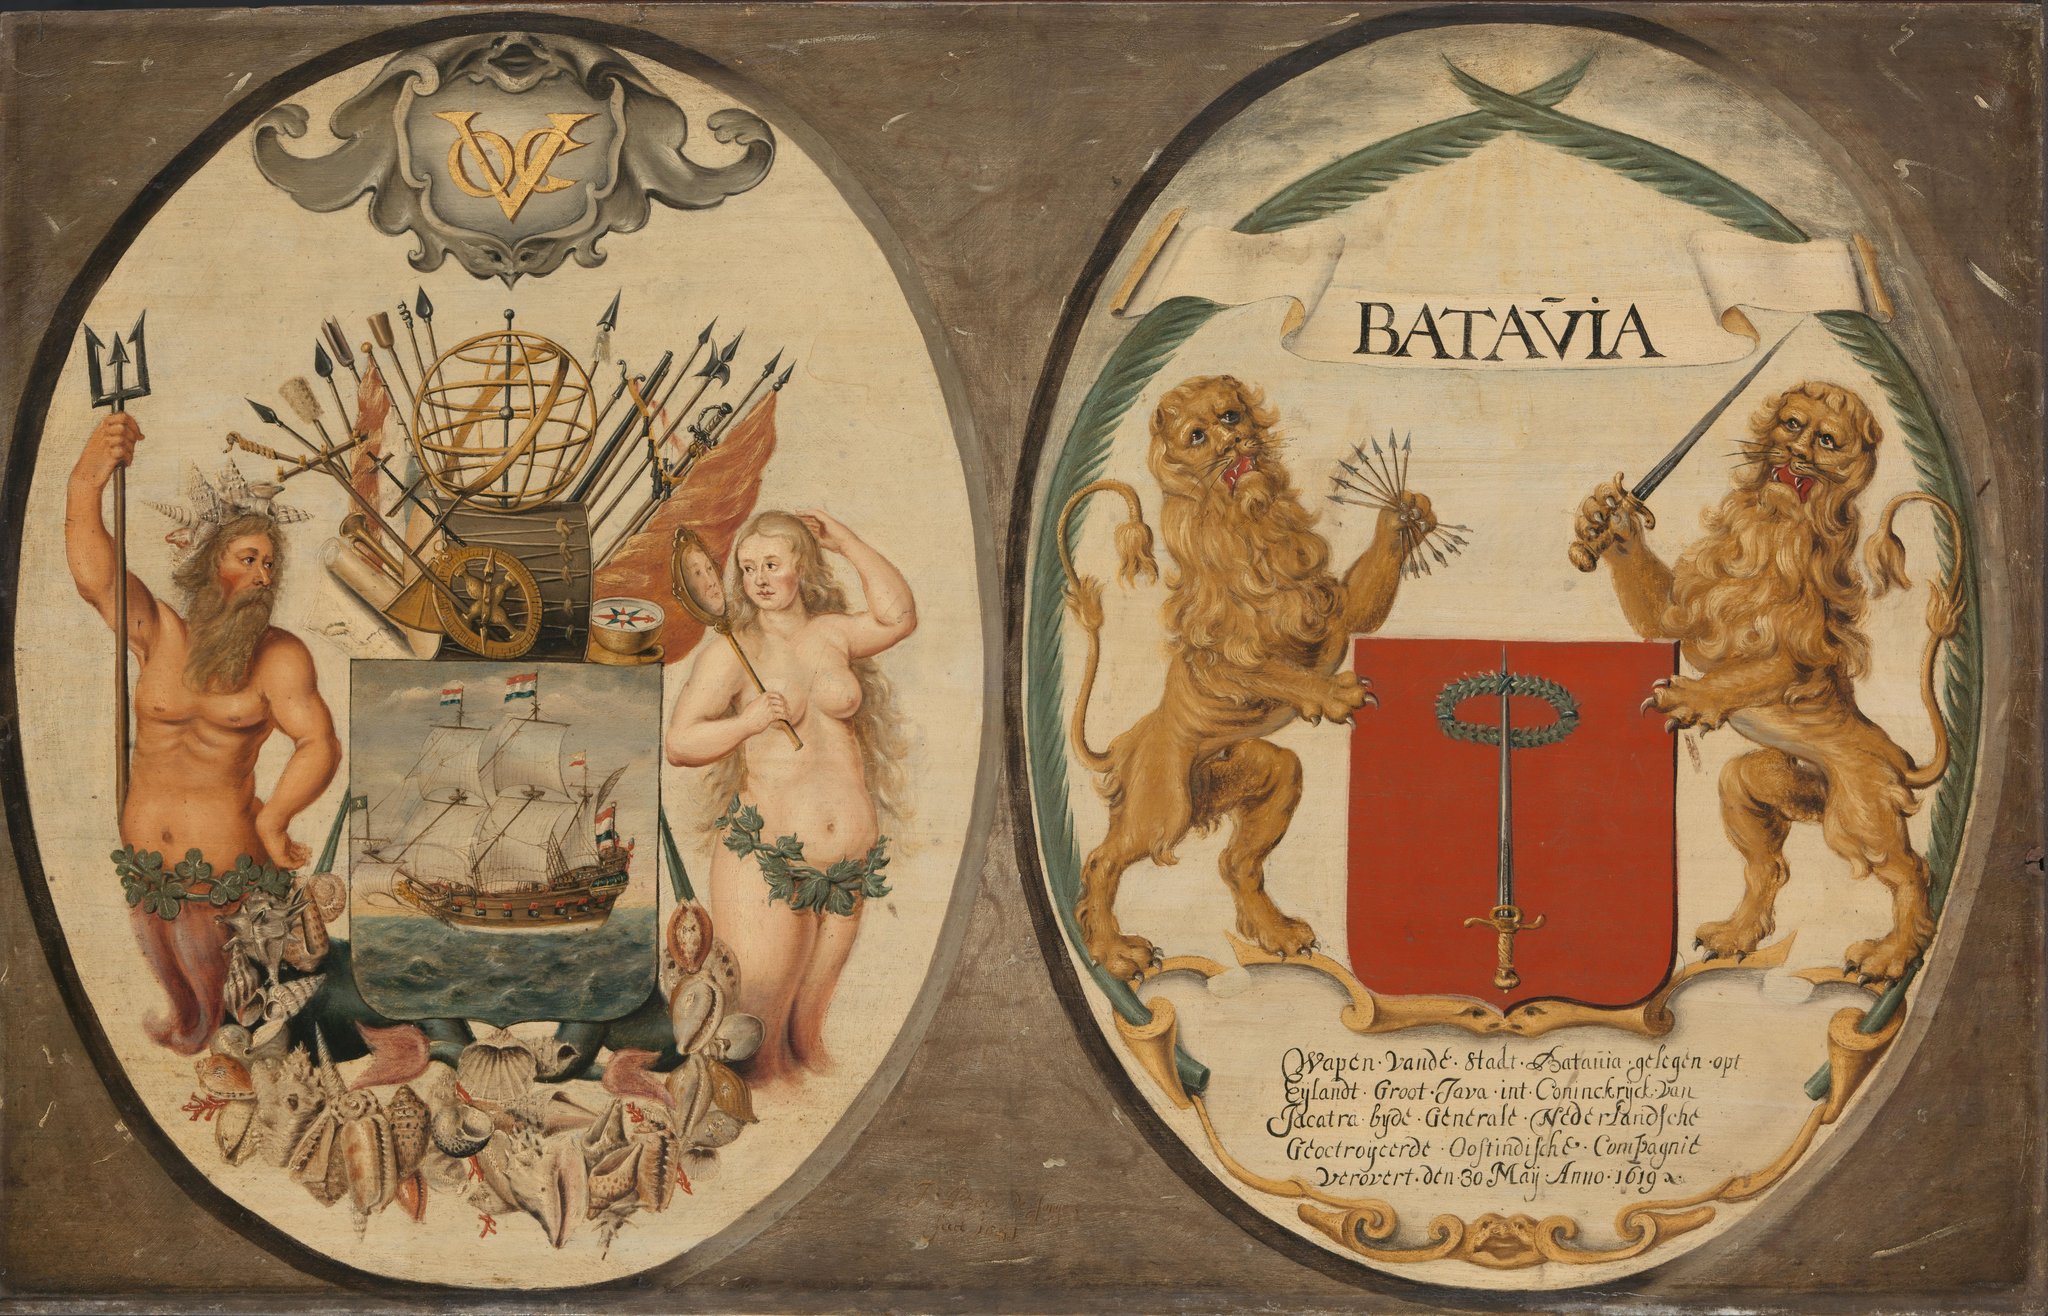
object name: family arm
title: The Arms of the Dutch East India Company and of the Town of Batavia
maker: jeronimus becx (ii)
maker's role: painter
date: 1651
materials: oil, panel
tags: coat of arms (as symbol of the state, etc.) (+ city; municipal), batavia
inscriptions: inscription: ‘Wapen Vande Stadt Batavia gelegen opt Eijlandt Groot Java int Coninckrijck Van Jacatra bijde Generale Nederlandsche Geoctroyeerde Oostindische Compagnie Verovert den 30 Maij Anno 1619’, signature and date: ‘J. Becx de Jonge fecit 1651’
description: These shields feature the arms of the Dutch East India Company, ornamented with Neptune and a mermaid, and those of Batavia, flanked by Dutch lions. According to the inscription on the latter, the city of Jacatra (now Jakarta) was ‘Conquered on 30 May in the year 1619’. That same year Governor-General Jan Pietersz Coen renamed it Batavia and built a castle with dockyards, warehouses and offices.